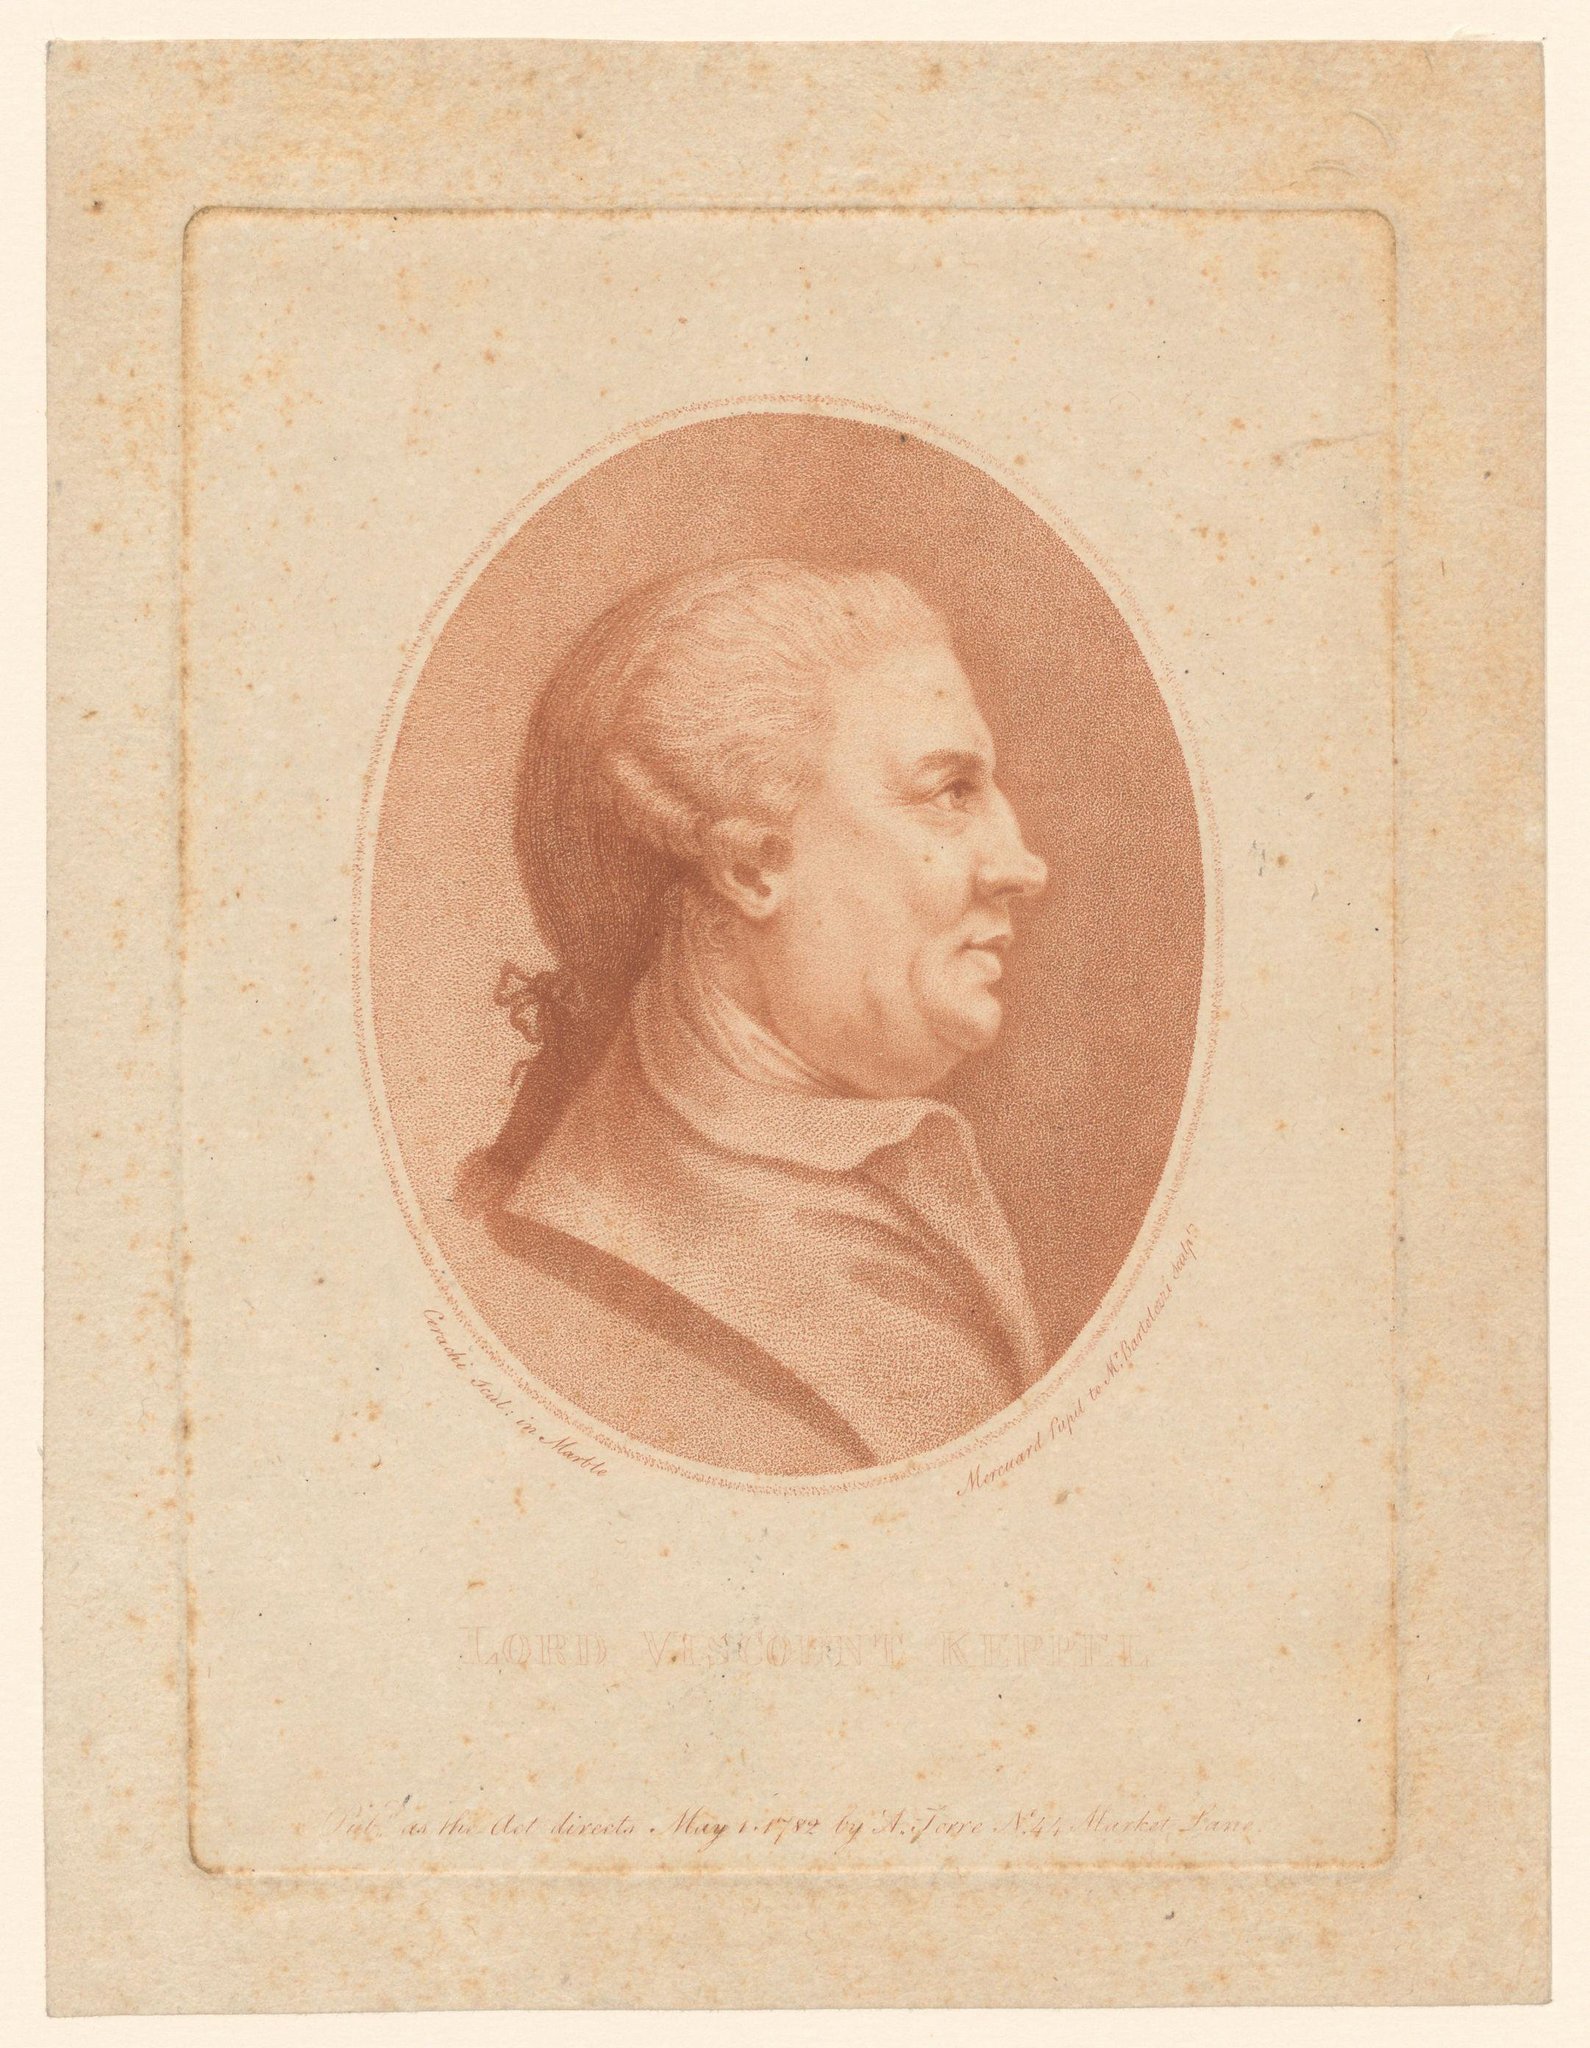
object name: print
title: Portret van Augustus Keppel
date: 1782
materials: paper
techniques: etching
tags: london, politician, historical persons, commander-in-chief, admiral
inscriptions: collector's mark: Lugt 2228